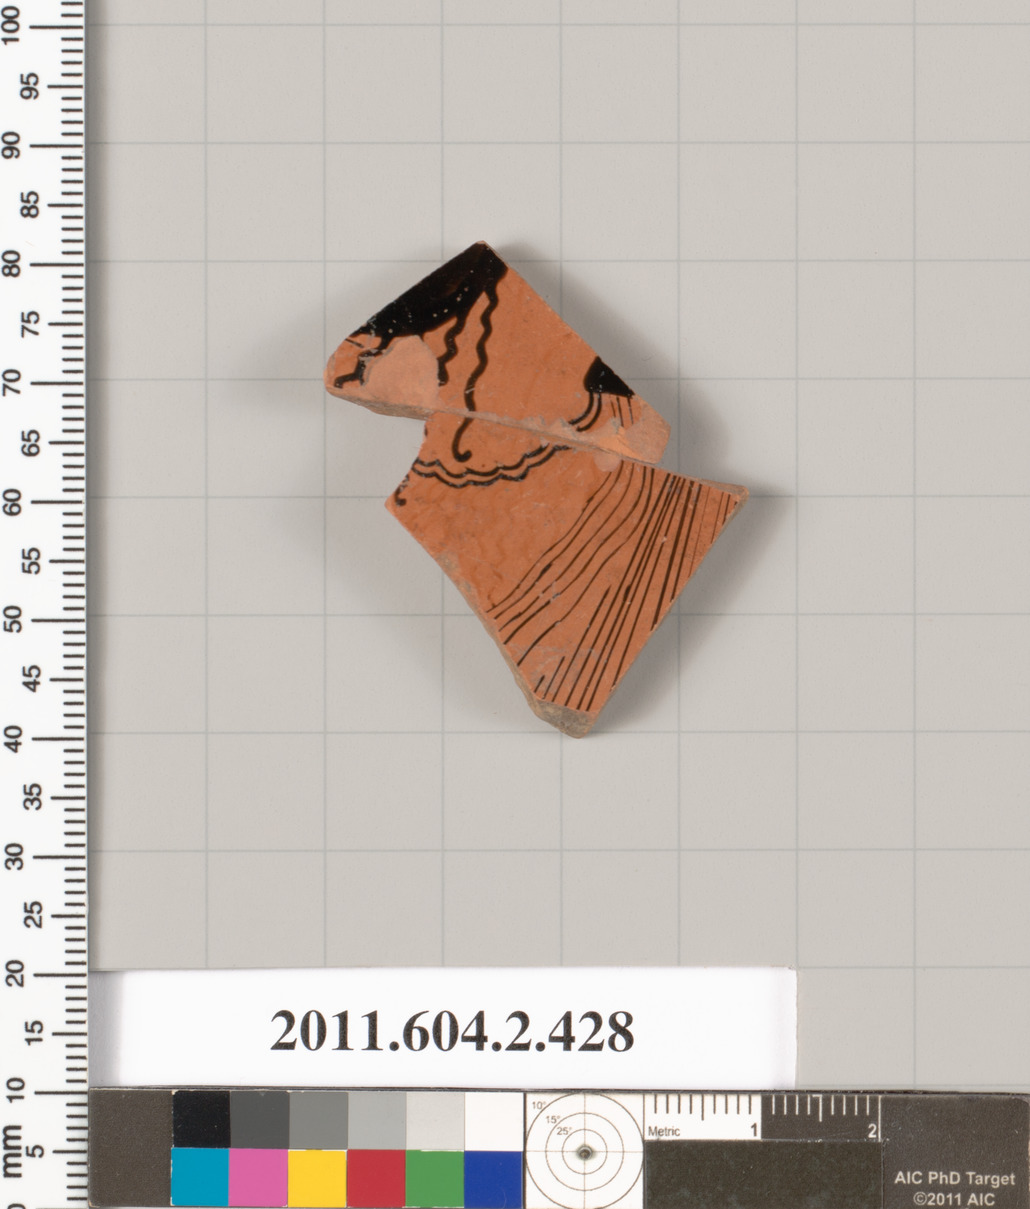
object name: column krater fragment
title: Terracotta fragment of a column-krater (bowl for mixing wine and water)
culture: greek, attic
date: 460-440 BCE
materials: terracotta